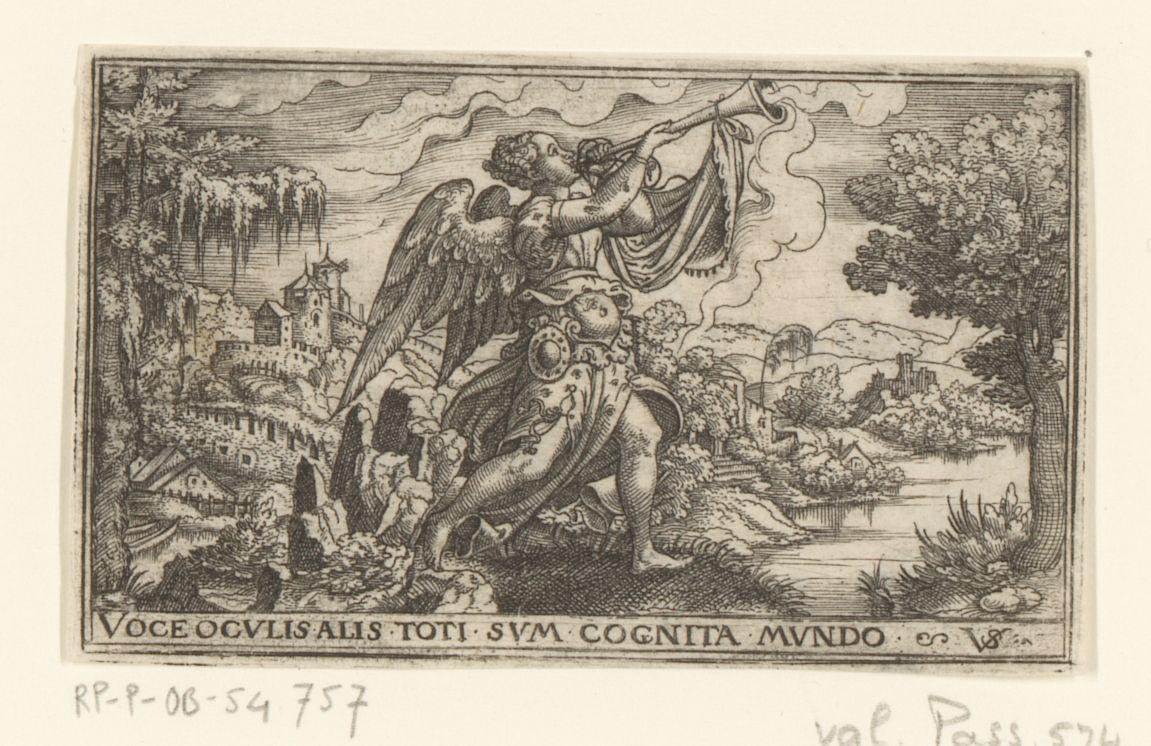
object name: print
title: Vrouwelijke allegorieën in landschappen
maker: virgilius solis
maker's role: draughtsman, print maker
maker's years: 1514-1562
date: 1524-1562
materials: paper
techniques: engraving, etching, intaglio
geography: nuremberg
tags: city-view, and landscape with man-made constructions, river, fama as roman personification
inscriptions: collector's mark: Lugt 2228, number: ‘72’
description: Prent maakt deel uit van een serie van zes prenten met vrouwelijke allegorieën in landschappen.